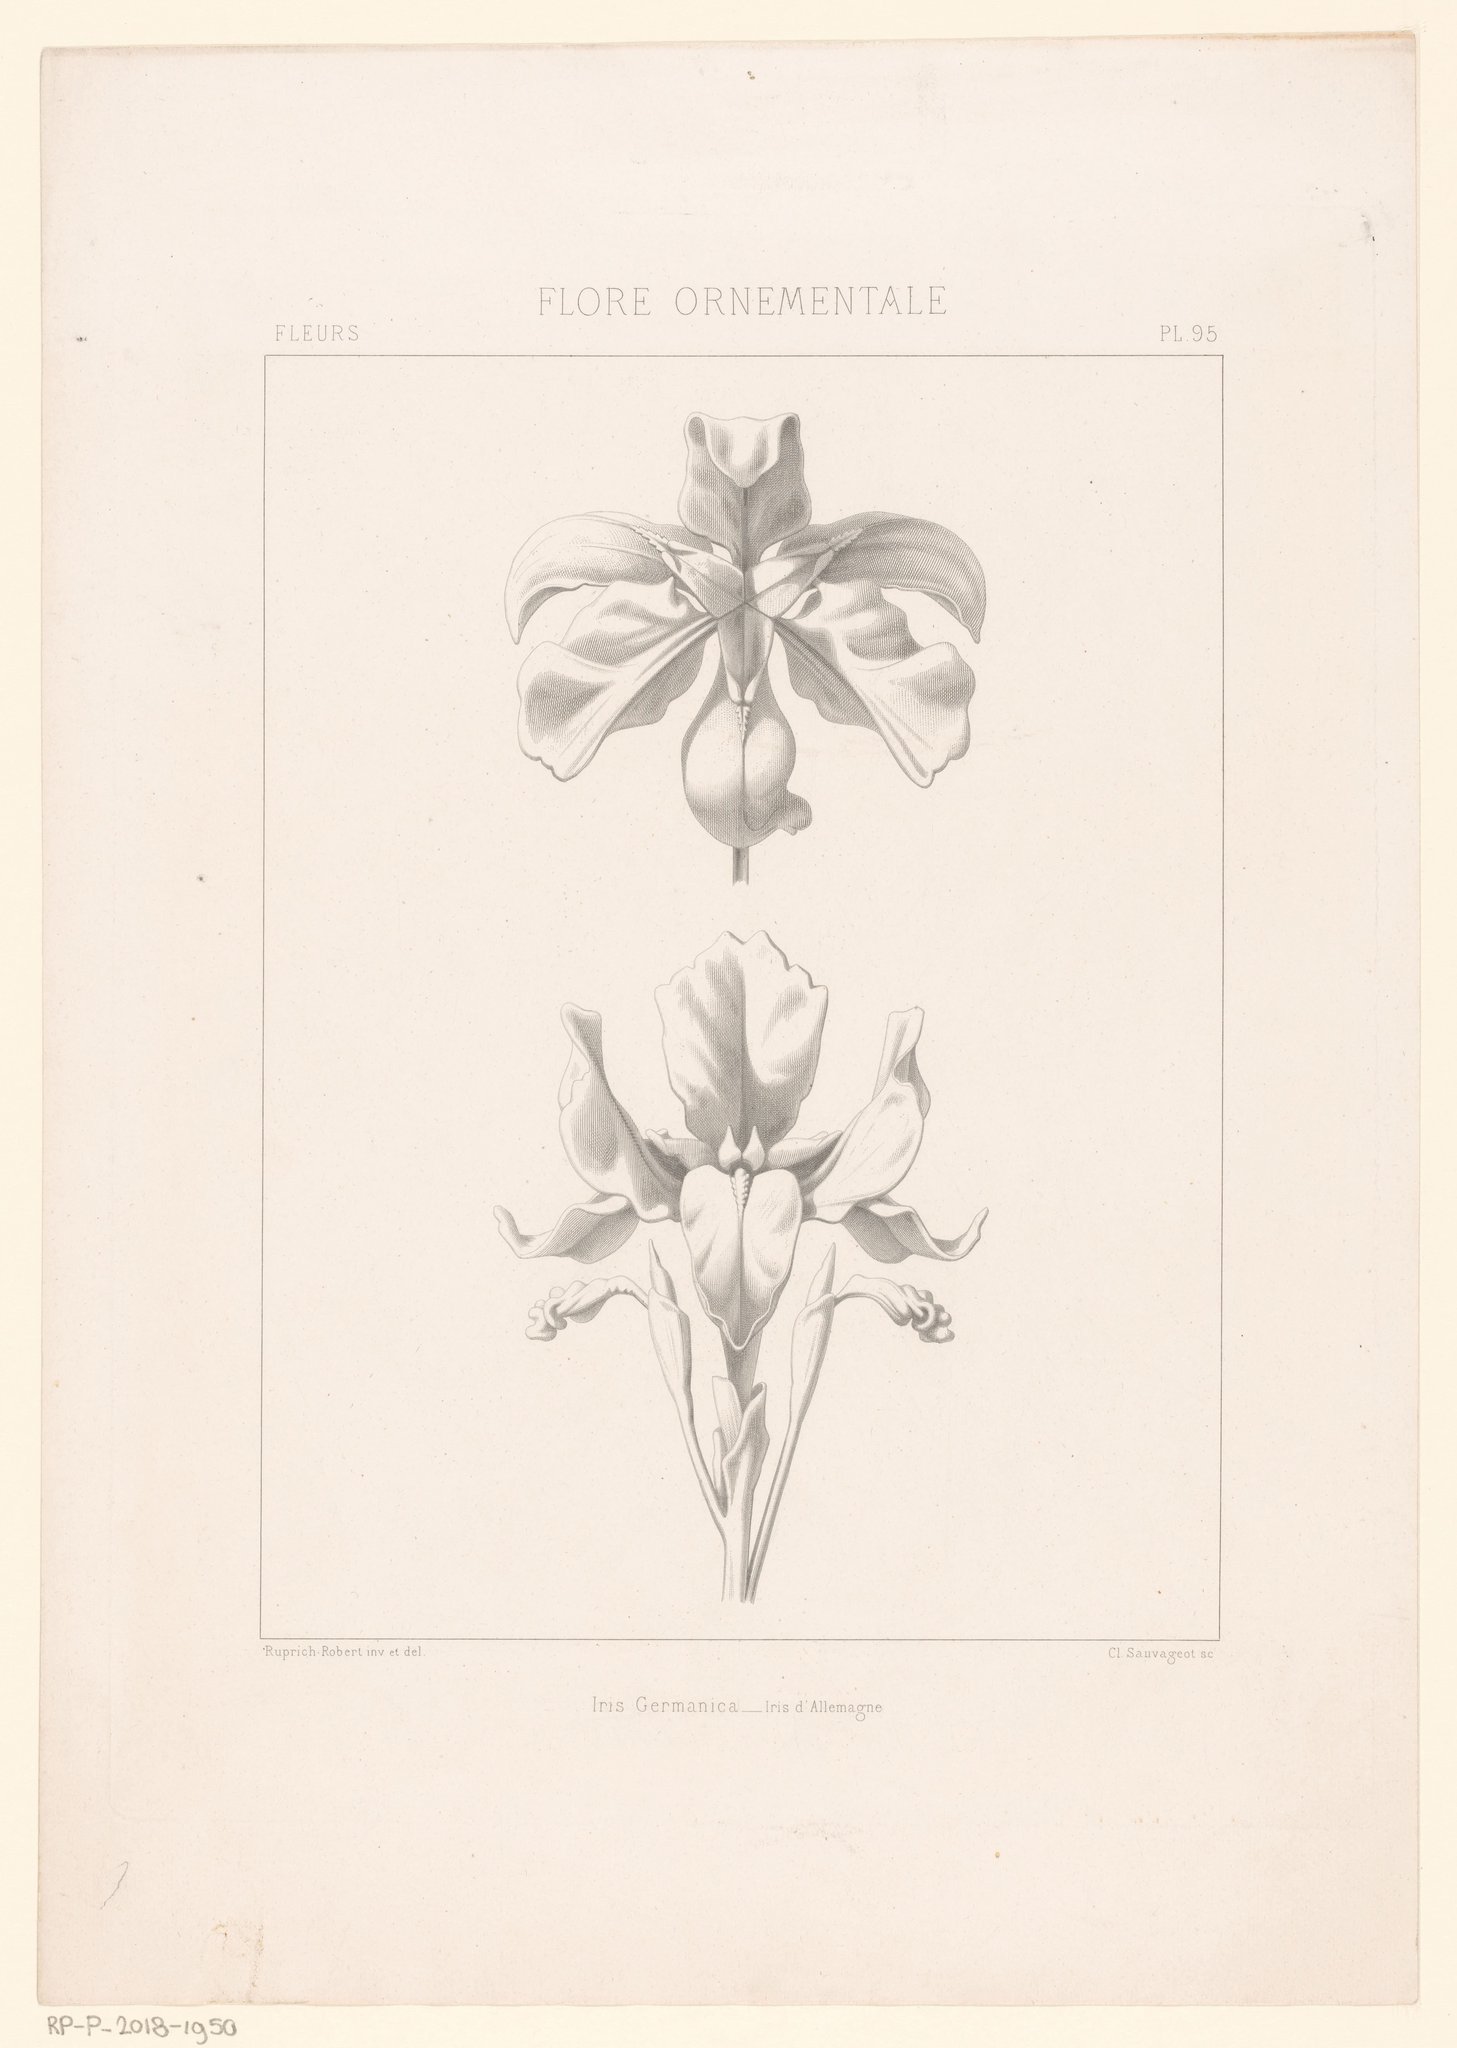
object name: book illustration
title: Studieblad met verschillende aanzichten van een iris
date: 1842-1885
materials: paper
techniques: engraving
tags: model-books ~ implements of painter, flowers ~ ornament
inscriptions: collector's mark: Lugt 3937, collector's mark: Lugt 2228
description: Prent uit: Ruprich-Robert, Victor. Flore ornementale : essai sur la composition de l'ornement : éléments tirés de la nature et principes de leur application. Parijs: Dunod, 1876, nr. 95.